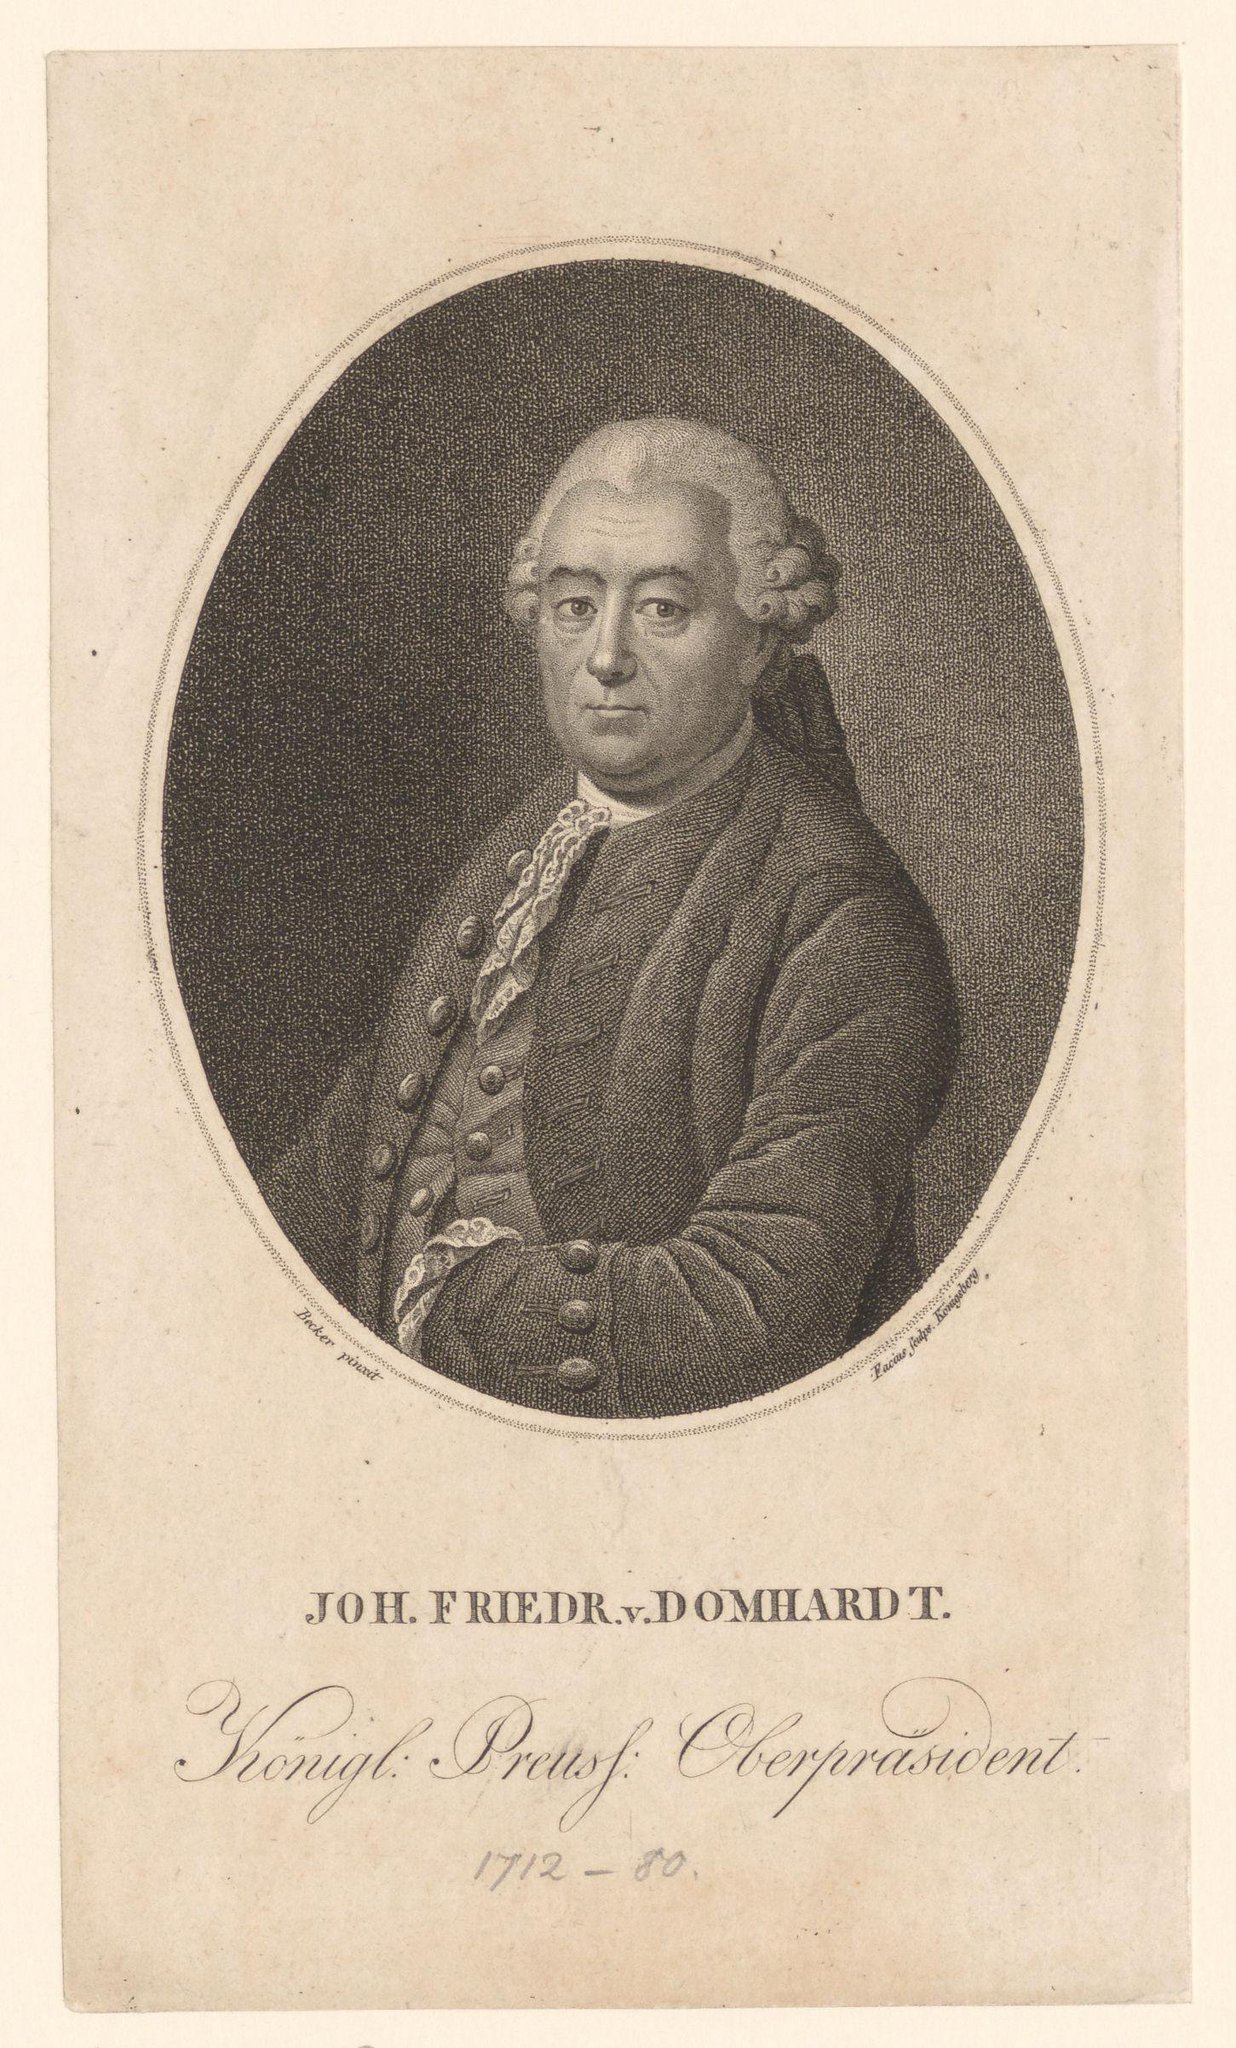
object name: print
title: Joh. Friedr. v. Domhardt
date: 1760-1814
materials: paper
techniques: etching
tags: politician, historical persons, politician, e.g. party leader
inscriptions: collector's mark: Lugt 2228